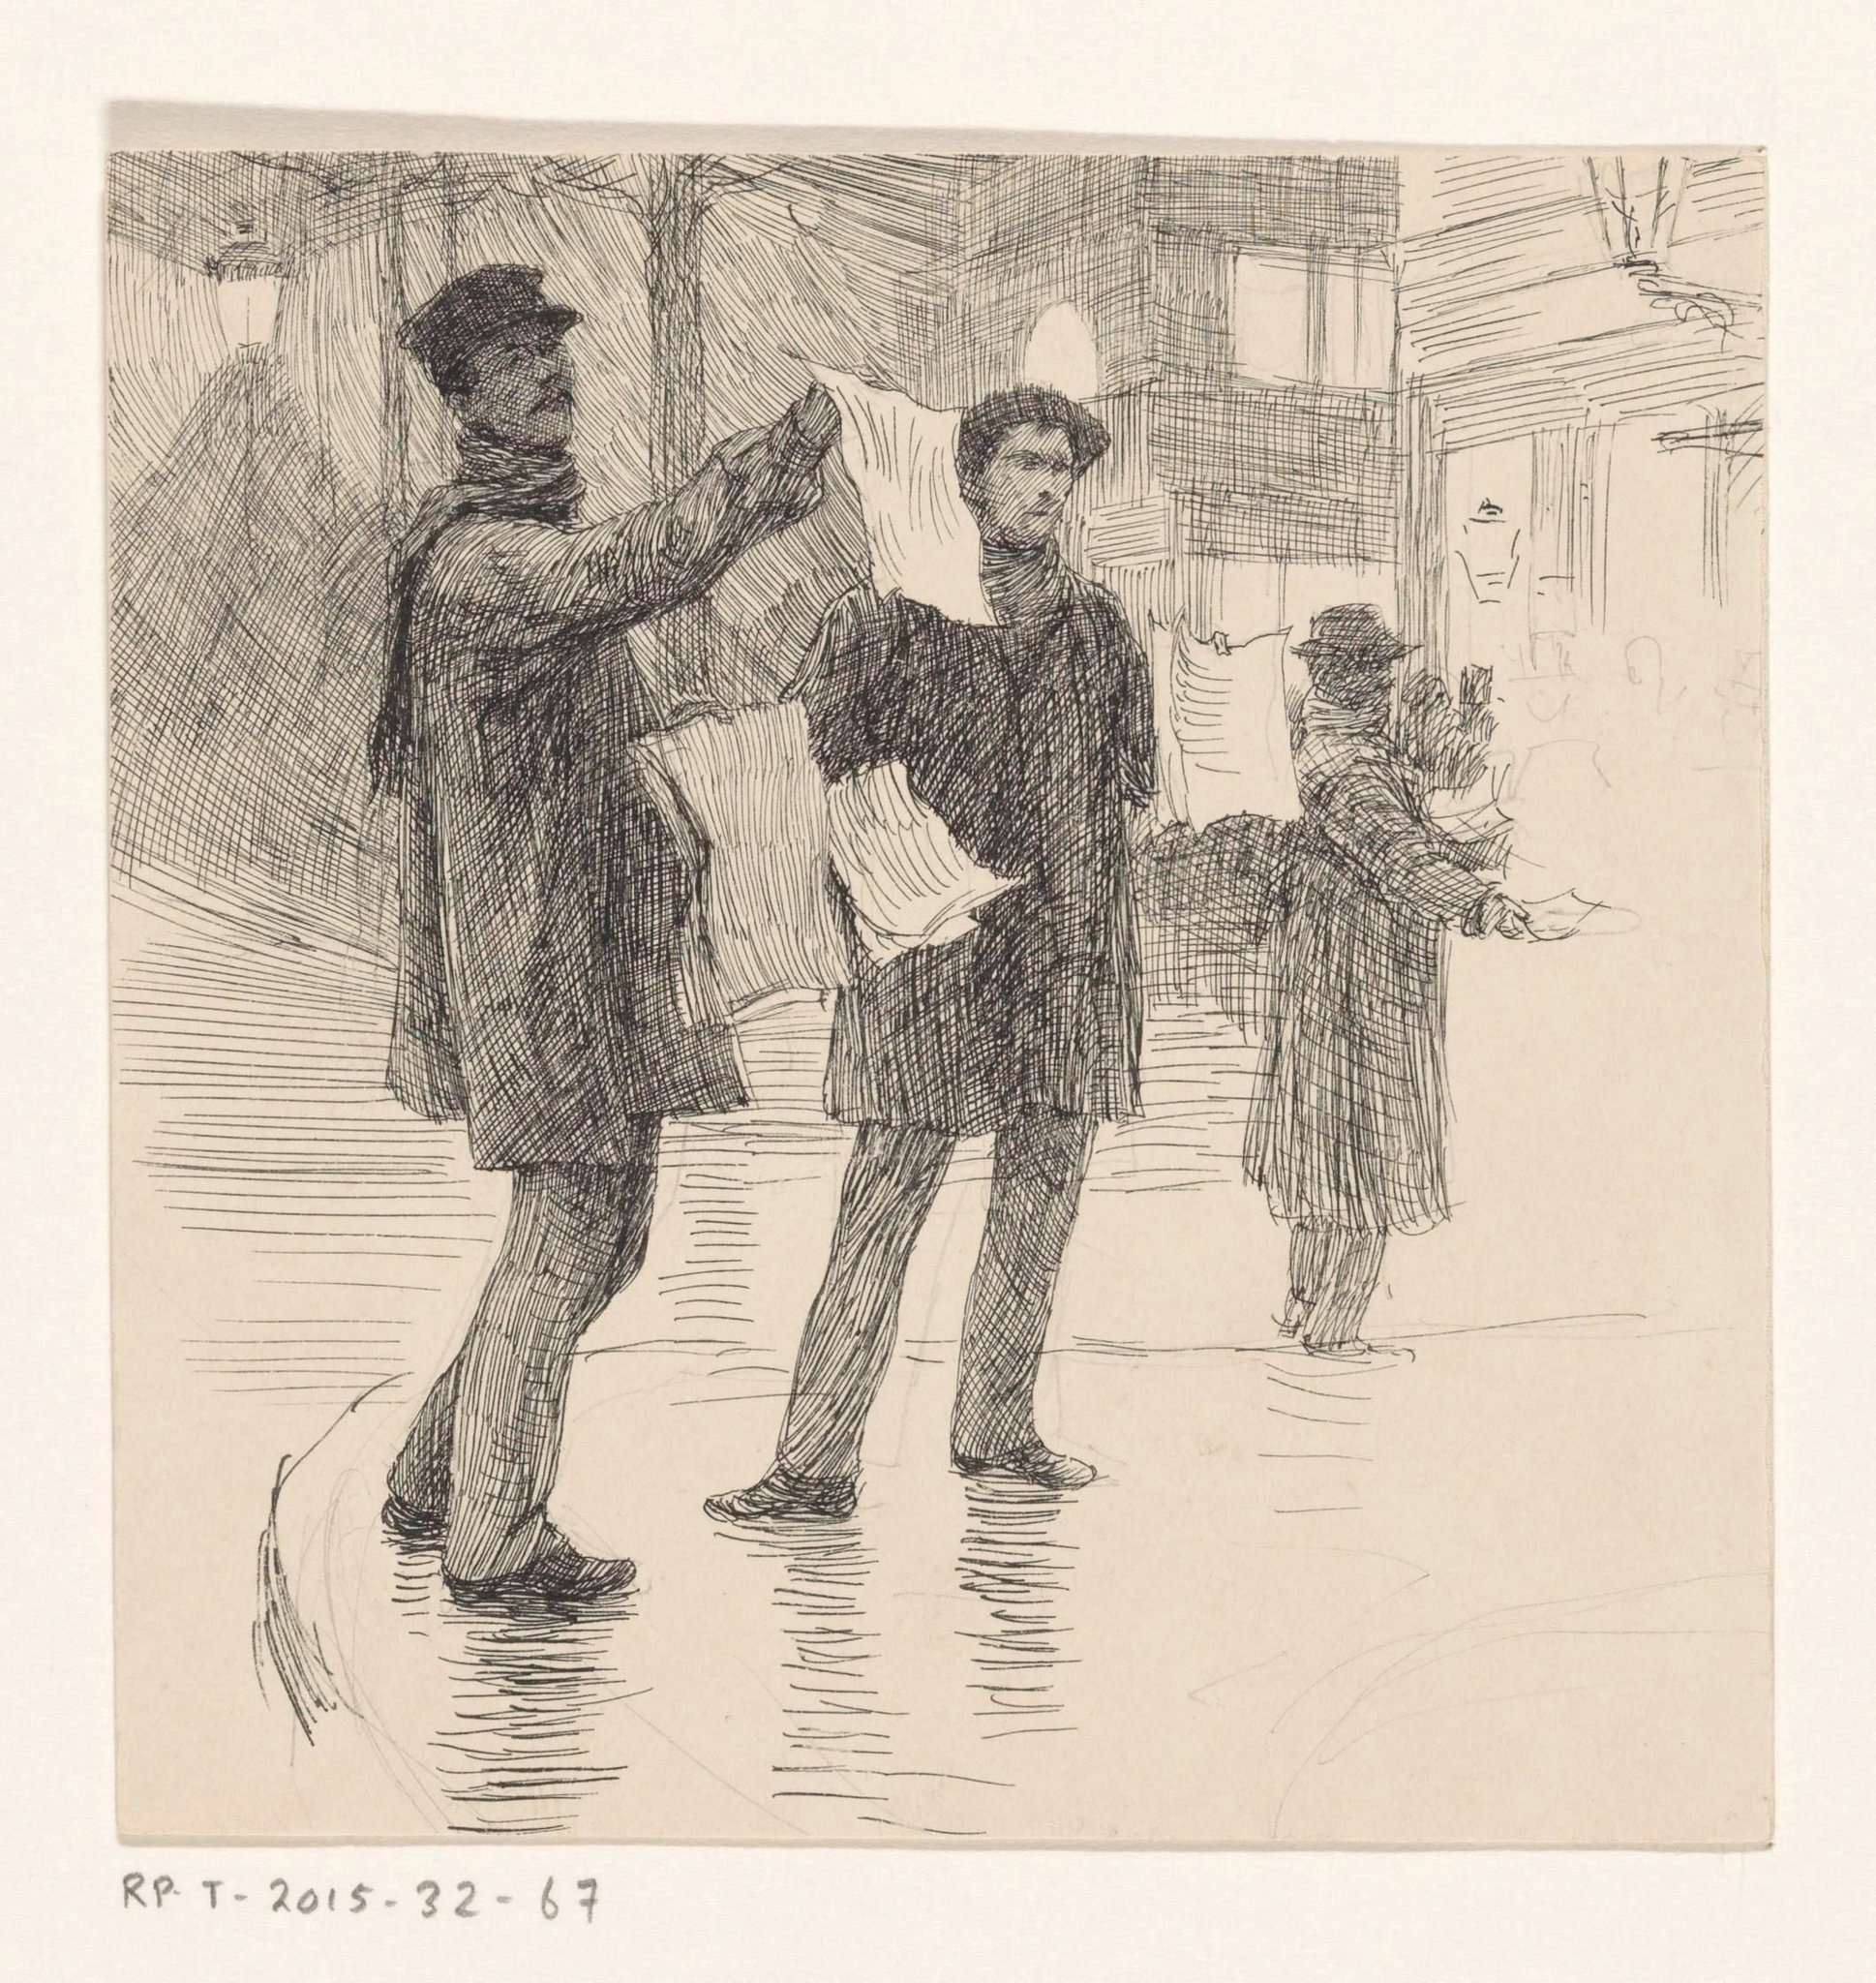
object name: print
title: Drie krantenverkopers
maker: felician myrbach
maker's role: draughtsman, painter, print maker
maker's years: 1853-1940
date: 1863-1940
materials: ink, paper, pencil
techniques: pen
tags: newsboy, newsman, sale of newspaper, newspaper stand, street-trader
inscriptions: collector's mark: Lugt 4780, collector's mark: Lugt 2228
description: Op verso een potloodschets met penseel in kleuren.